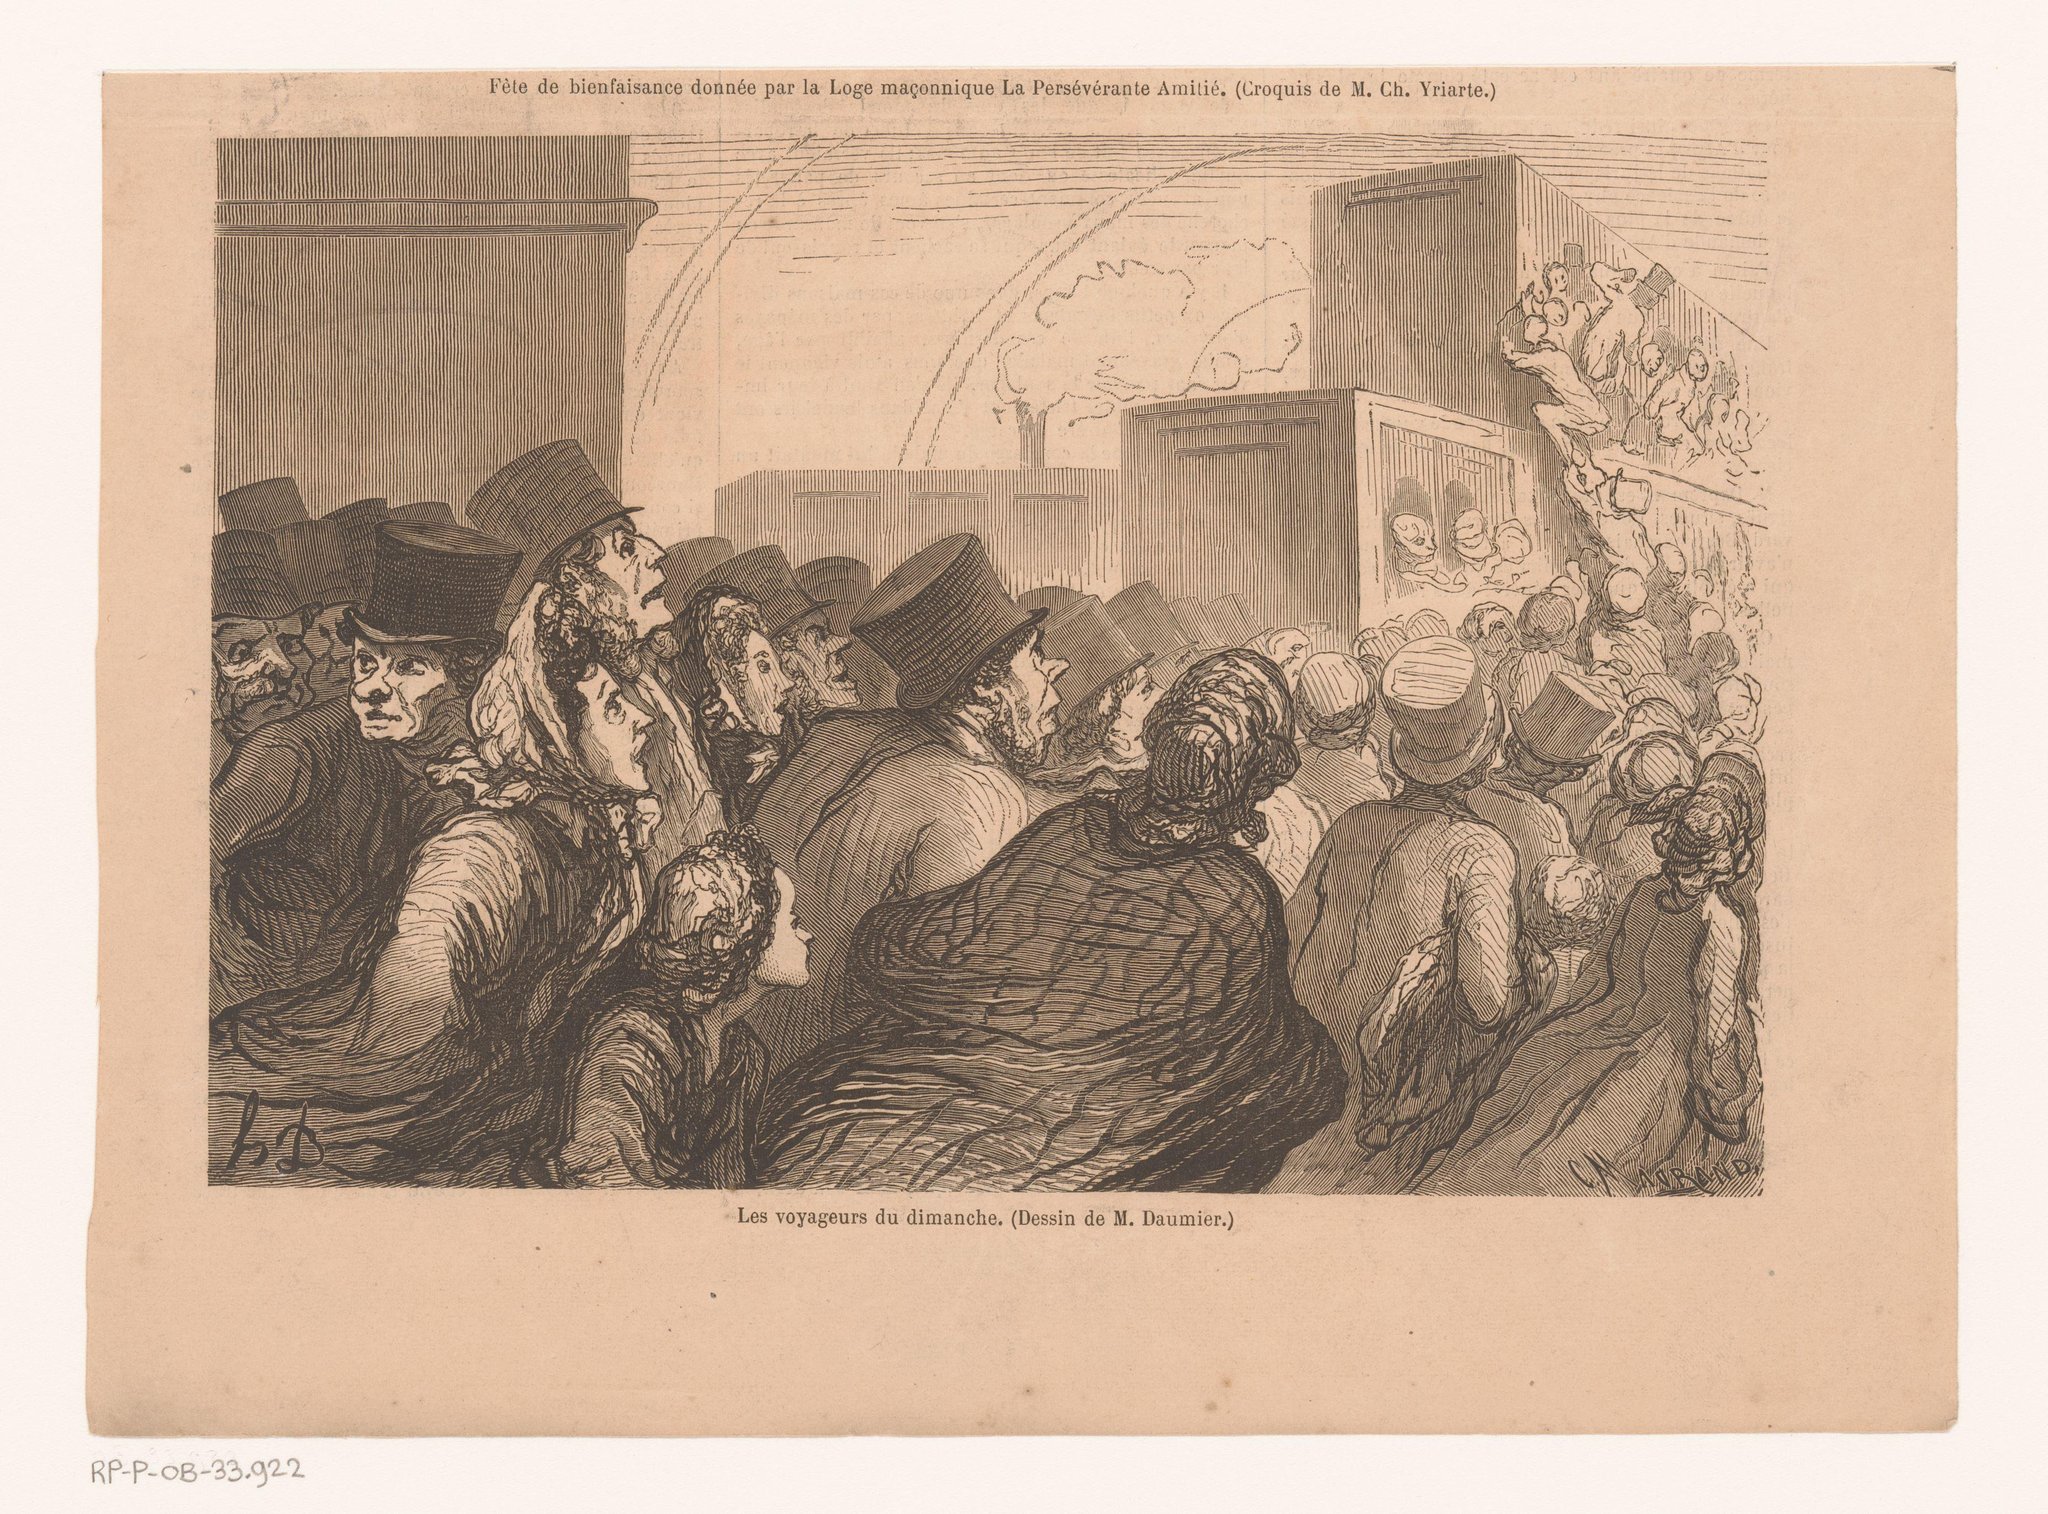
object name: print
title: Groep reizigers op treinstation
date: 1862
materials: paper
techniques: letterpress printing, engraving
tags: station; shelter (railway, tramway), departure ~ travelling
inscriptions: collector's mark: Lugt 2228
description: Gebruikt als illustratie in: Le Monde illustré, 3 mei 1862.